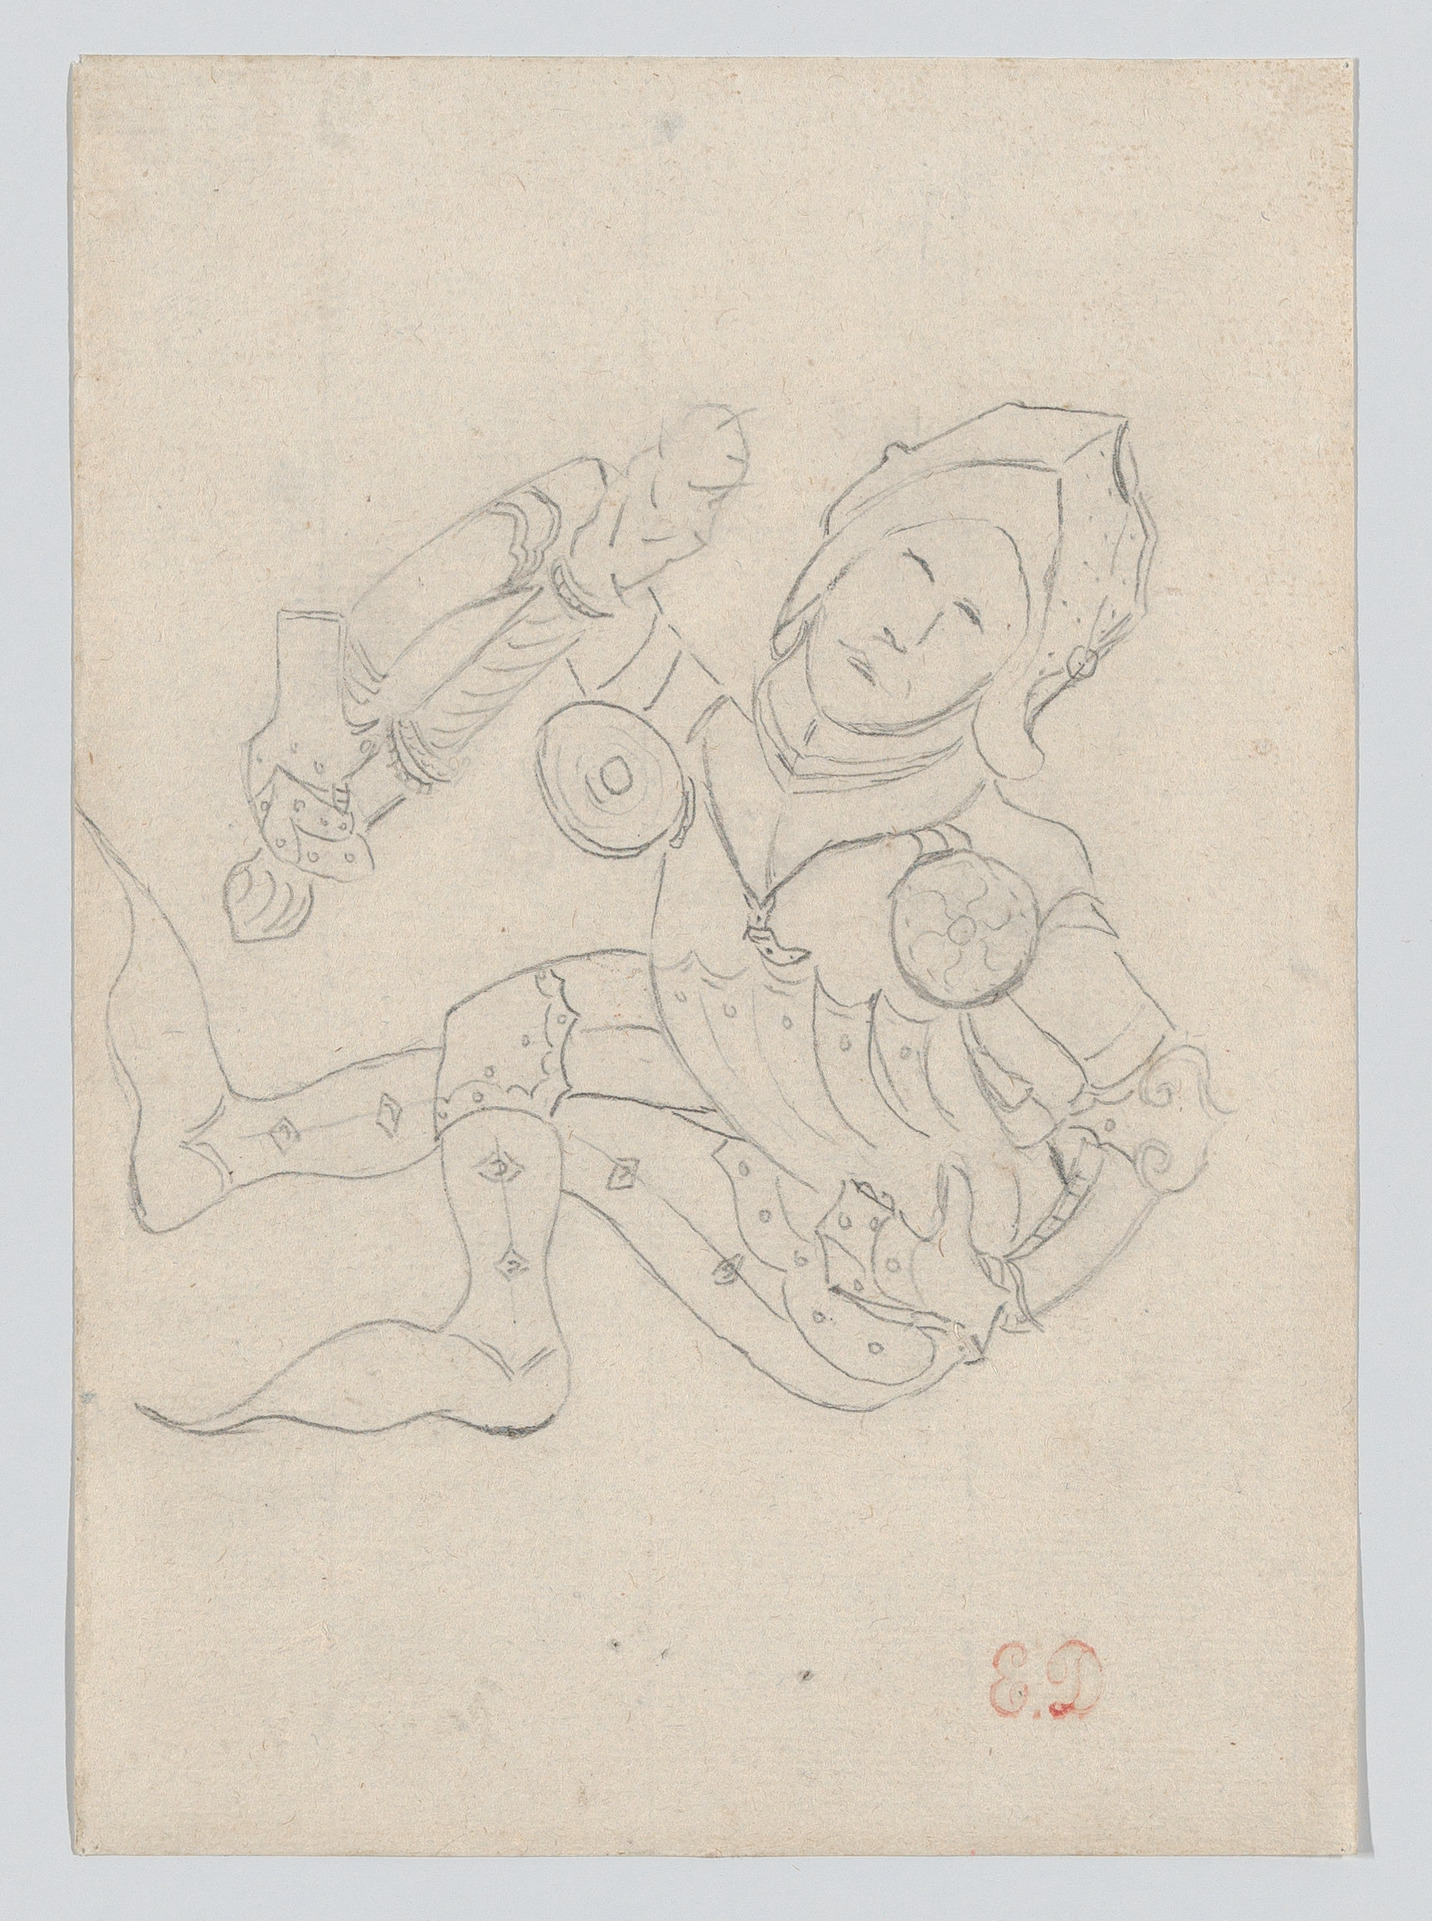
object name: drawing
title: Study of a Fallen Soldier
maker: eugène delacroix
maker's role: artist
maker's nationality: french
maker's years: 1798-1863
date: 1825-1830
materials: graphite